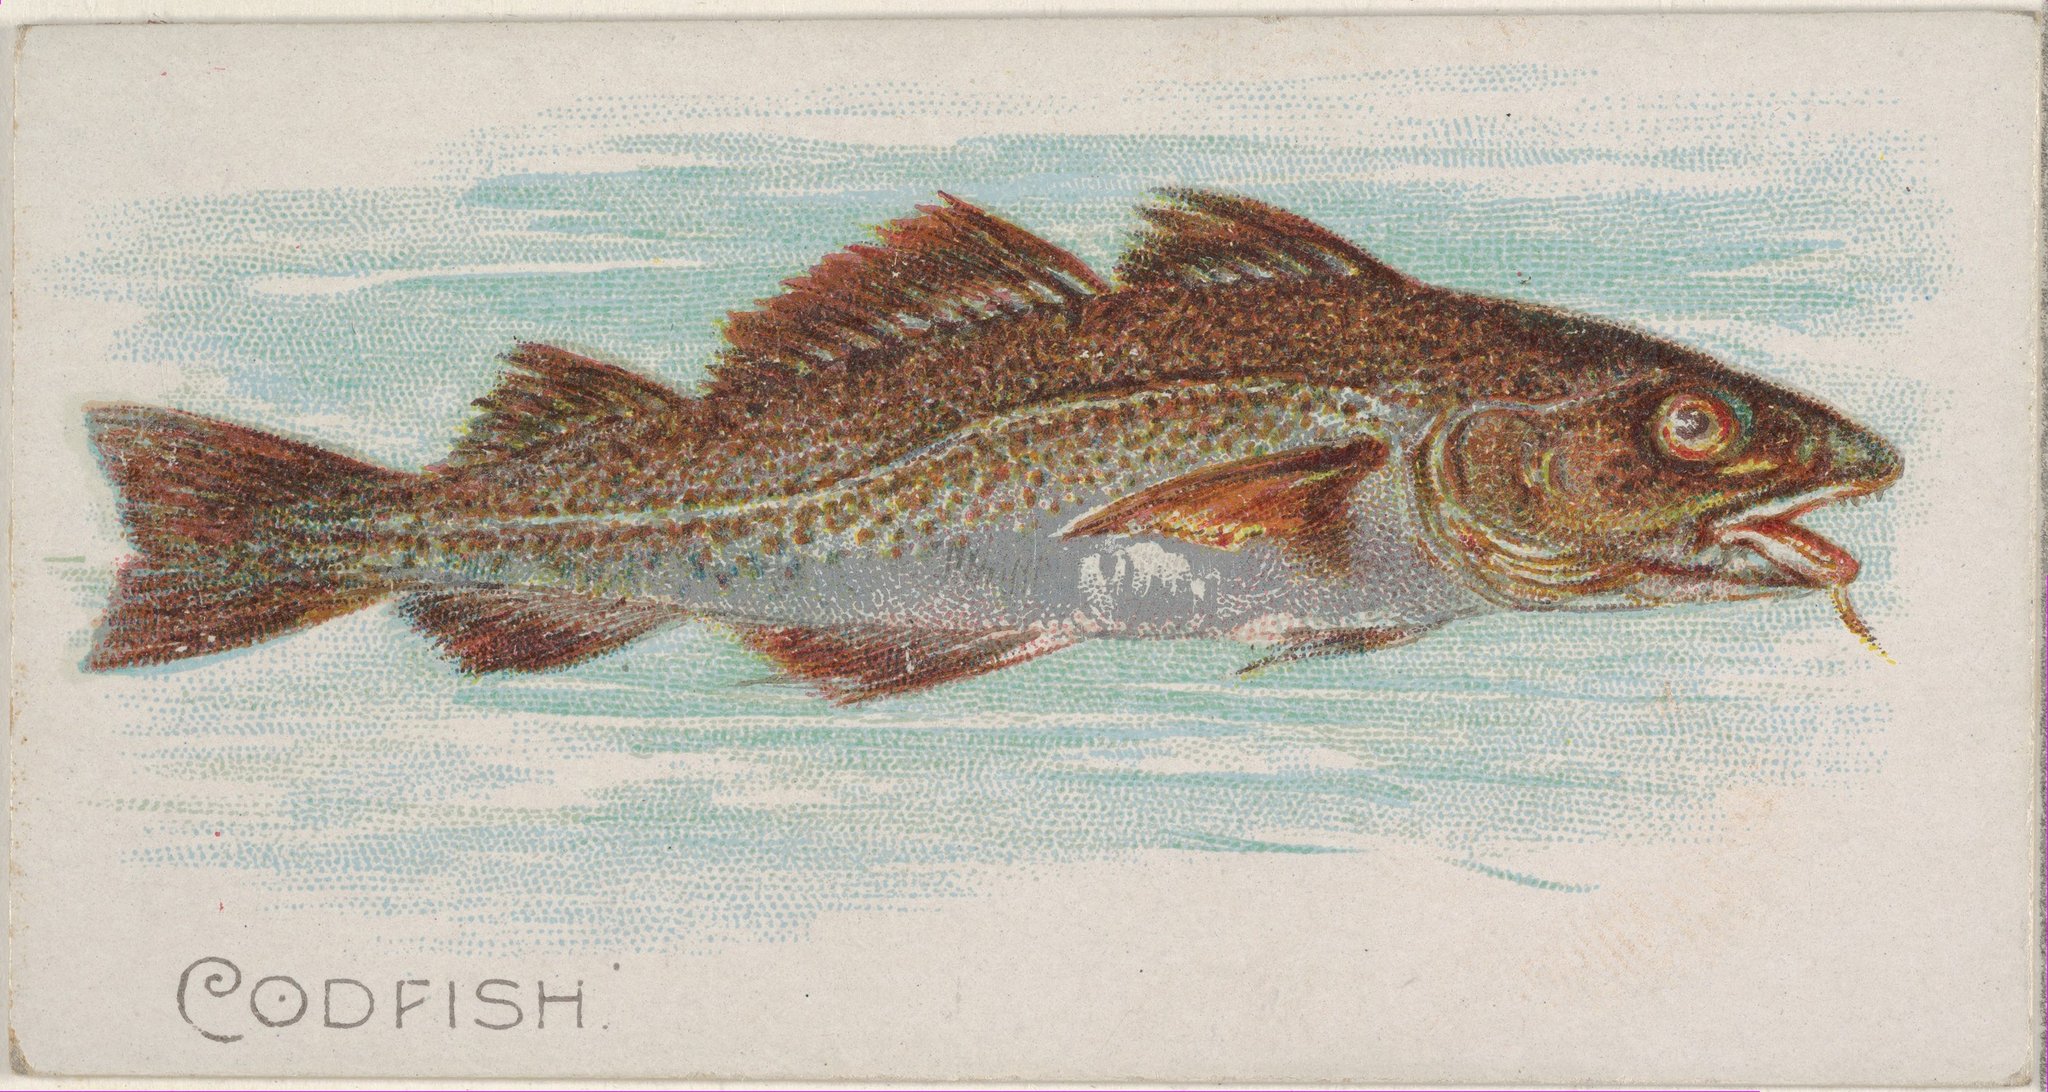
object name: print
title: Codfish, from the Fish from American Waters series (N8) for Allen & Ginter Cigarettes Brands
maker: allen & ginter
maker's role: publisher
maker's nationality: american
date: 1889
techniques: color lithograph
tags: fish